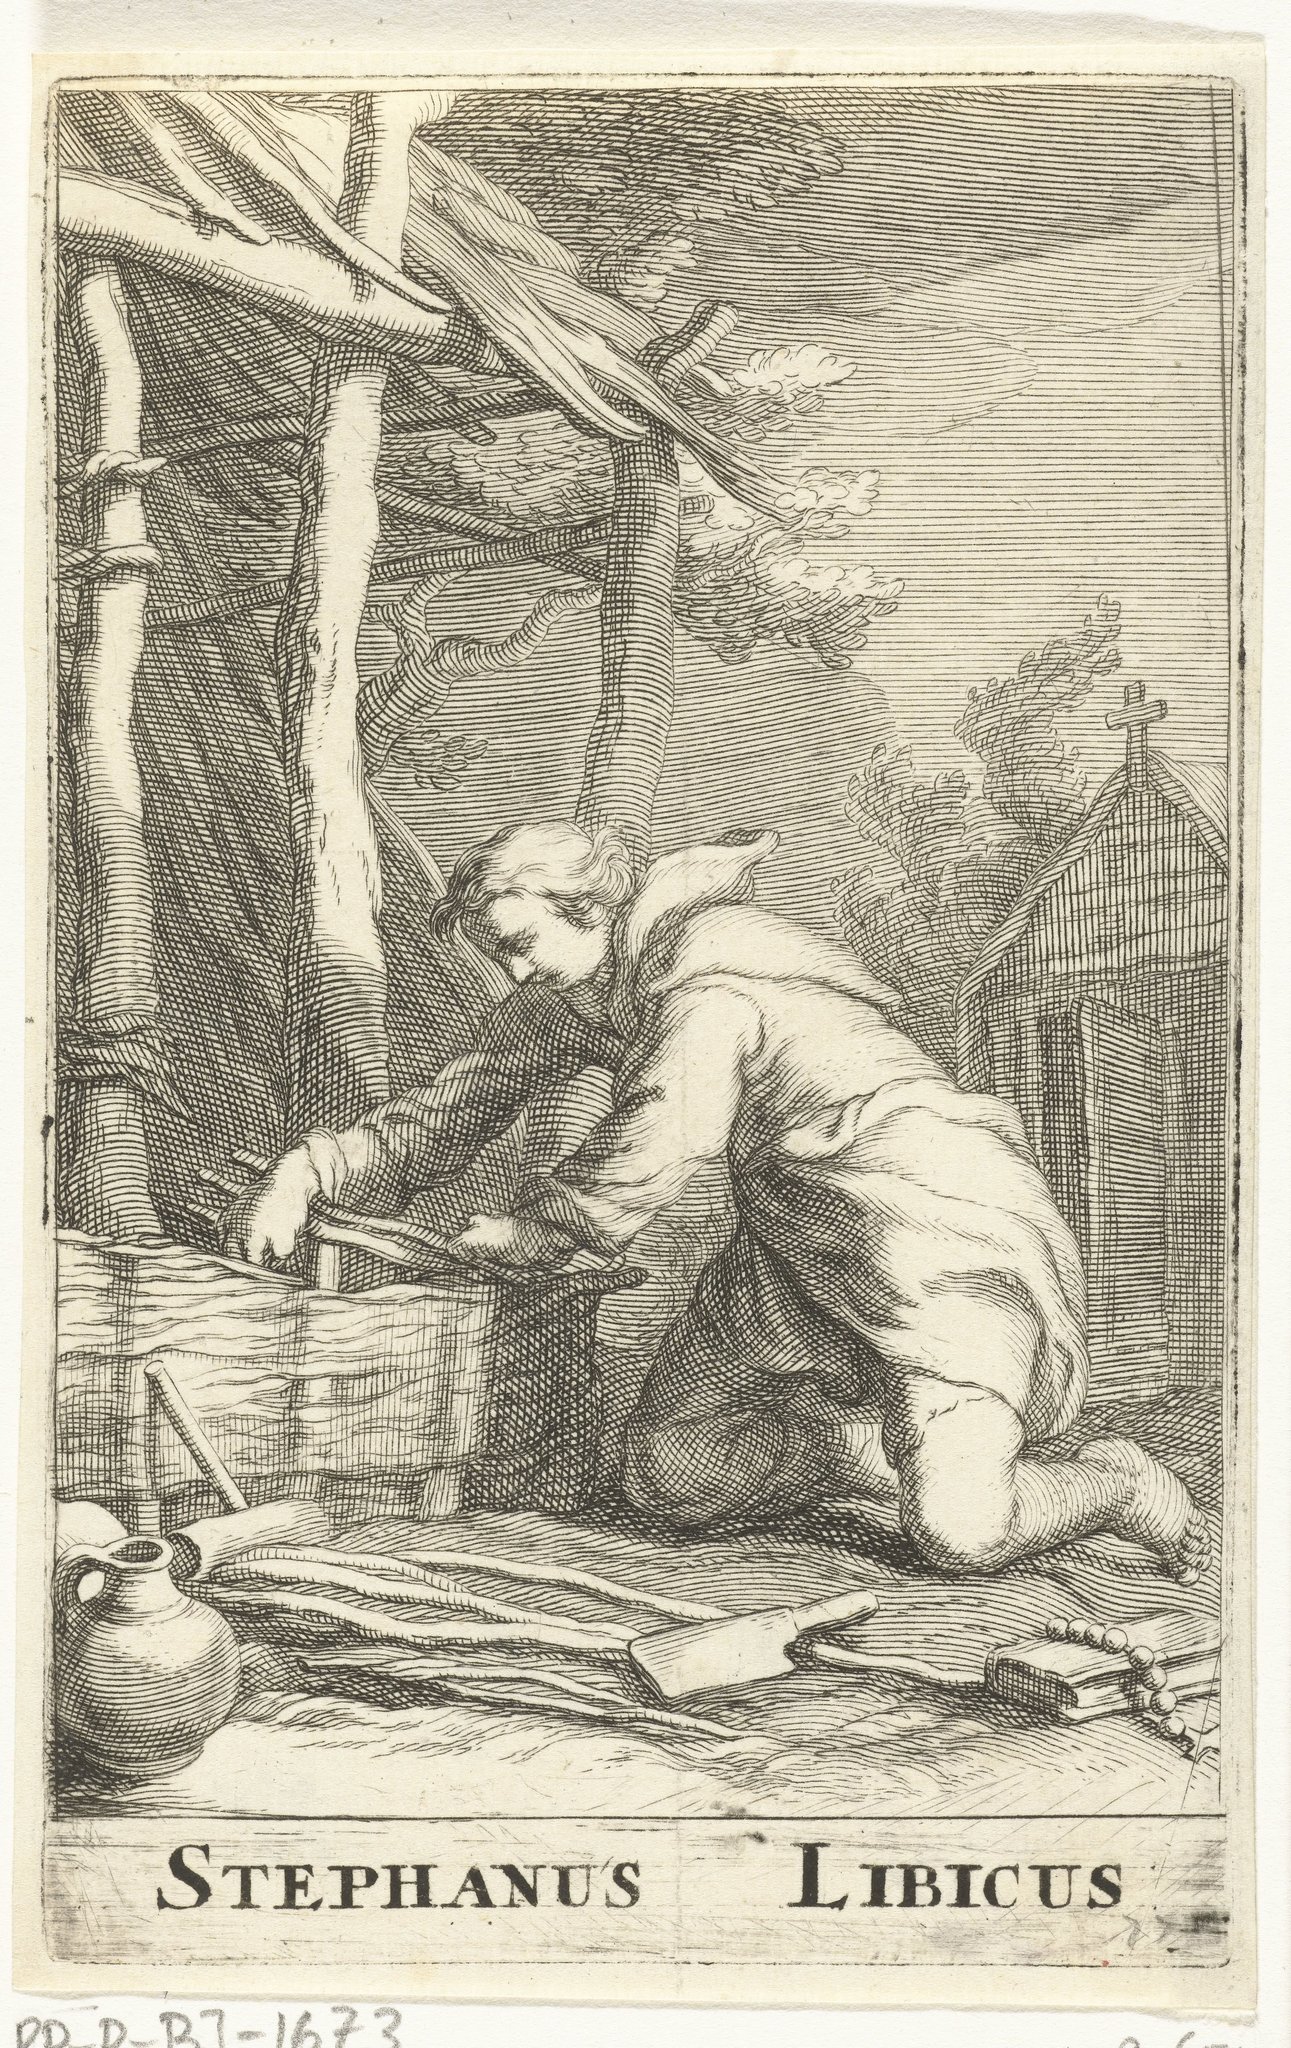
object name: print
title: Stephanus Libicus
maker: frederick bloemaert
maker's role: print maker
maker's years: 1614-1669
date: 1636-1670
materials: paper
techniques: engraving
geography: utrecht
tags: male saints (with name)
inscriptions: collector's mark: Lugt 240, number: ‘77’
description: De heilige Stephanus vlecht hier op zijn knieën een hekje van palmbladeren. Prent uit een serie van 80 prenten en een titelprent met kluizenaars uit de 2e tot de 6e eeuw.